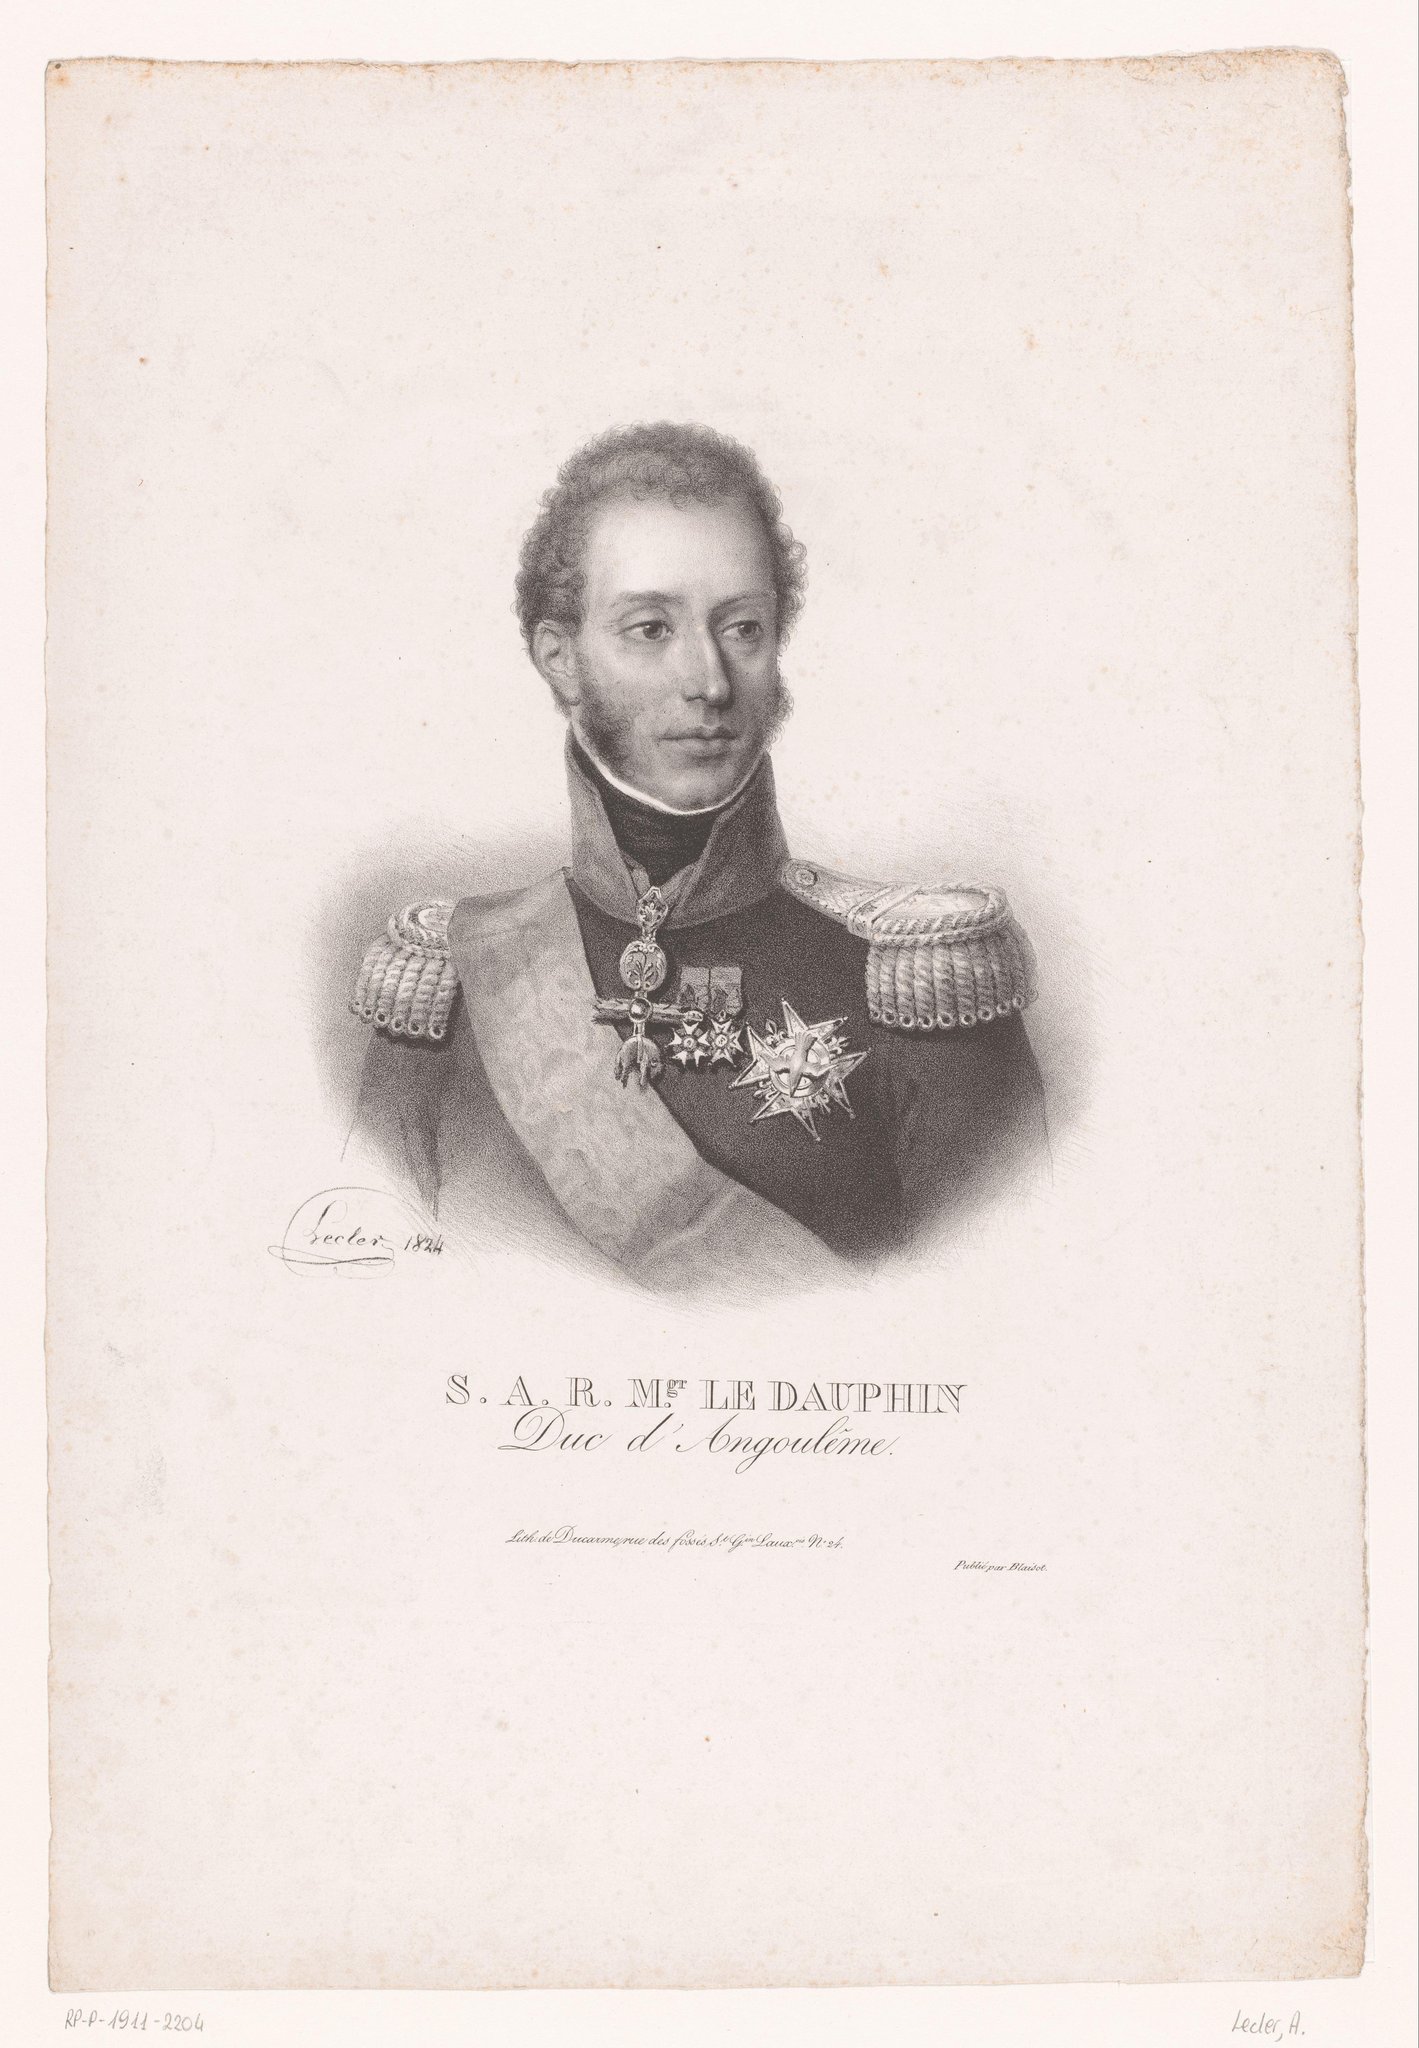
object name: print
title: S.A.R. M.gr le Dauphin, Duc d'Angoulême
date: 1824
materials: paper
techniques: lithograph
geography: paris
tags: historical persons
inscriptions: collector's mark: Lugt 2228a